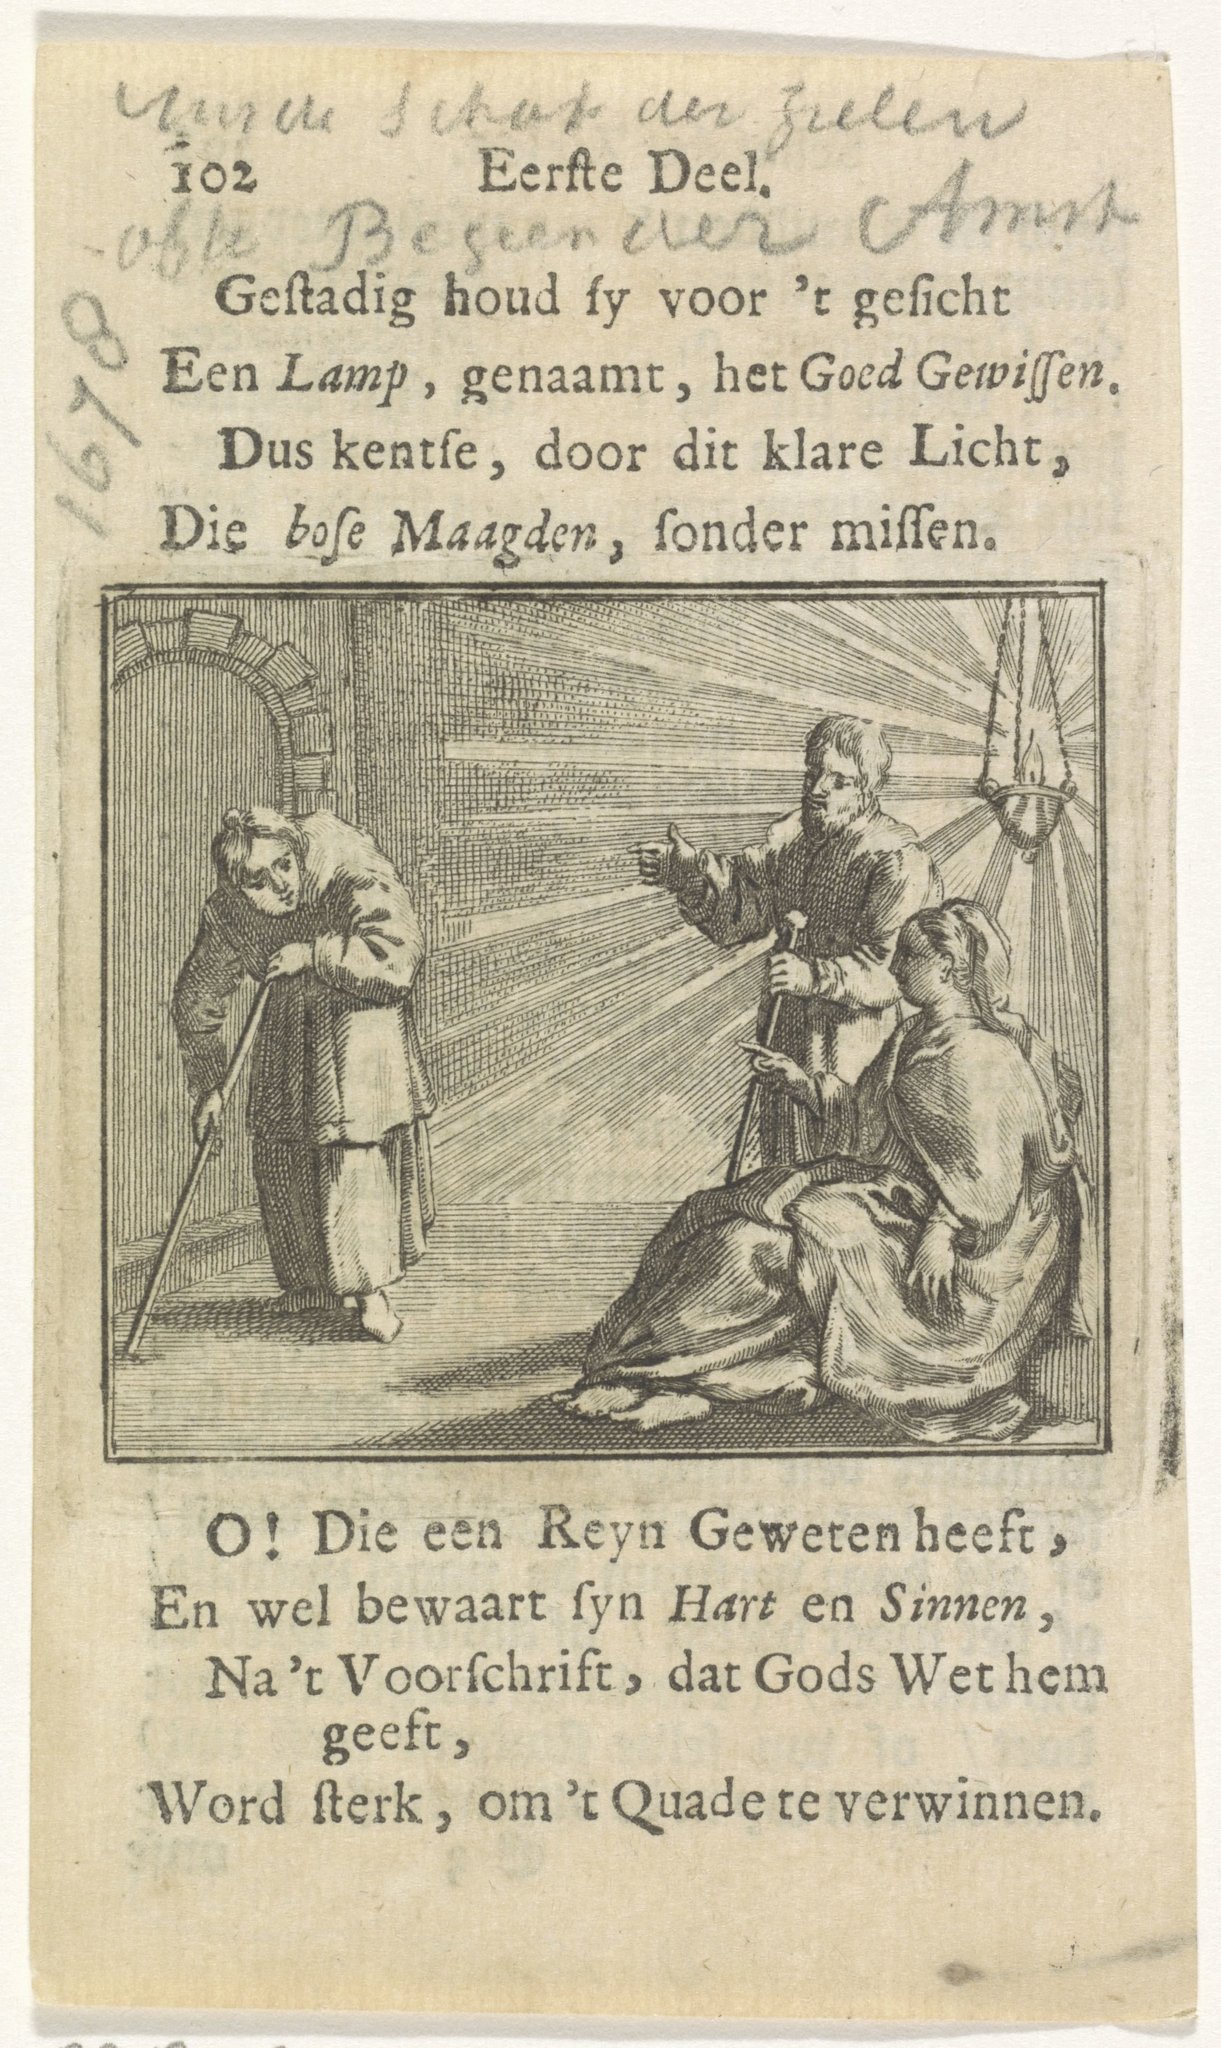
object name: book illustration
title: Man en vrouw bij olielamp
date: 1678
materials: paper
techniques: etching, letterpress printing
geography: netherlands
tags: oil-lamp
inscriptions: collector's mark: Lugt 2228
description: Prent gebruikt in: Comalada, Miguel. Schat der zielen, ofte Begeerder. Amsterdam: Pieter Arentsz (II), 1678.